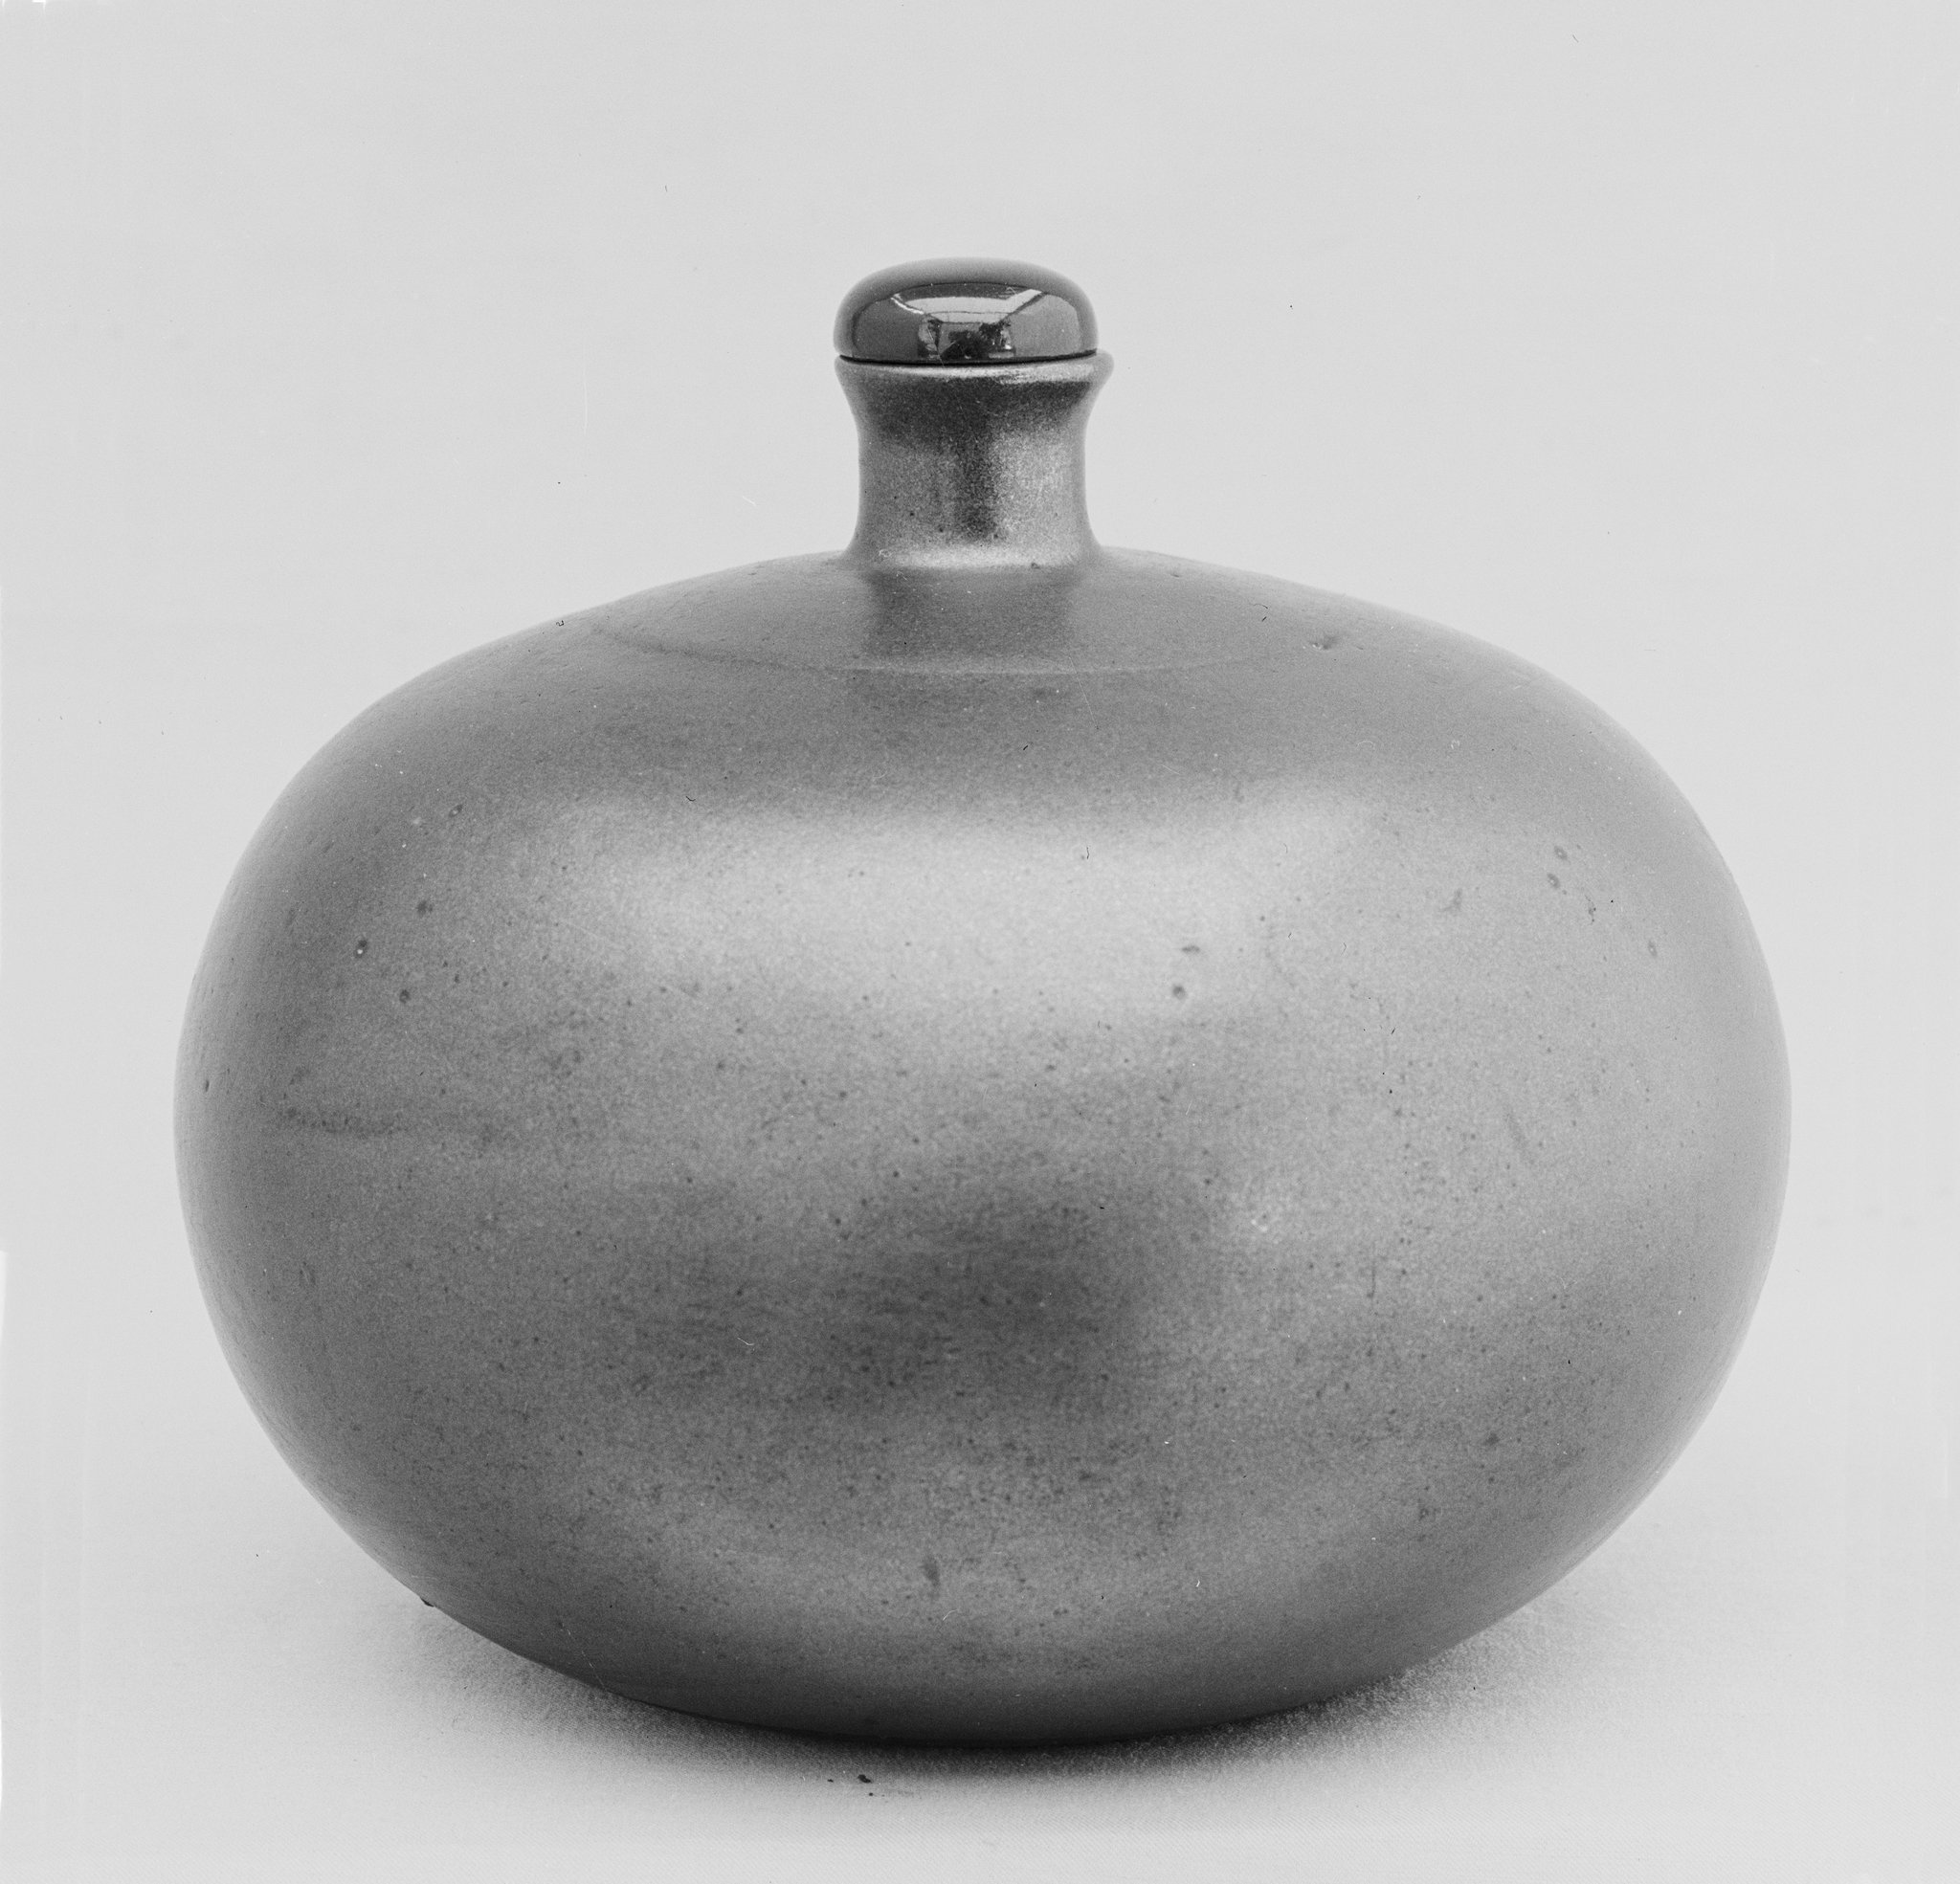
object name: bottle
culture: japanese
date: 1701-1800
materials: clay, glaze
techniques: stain